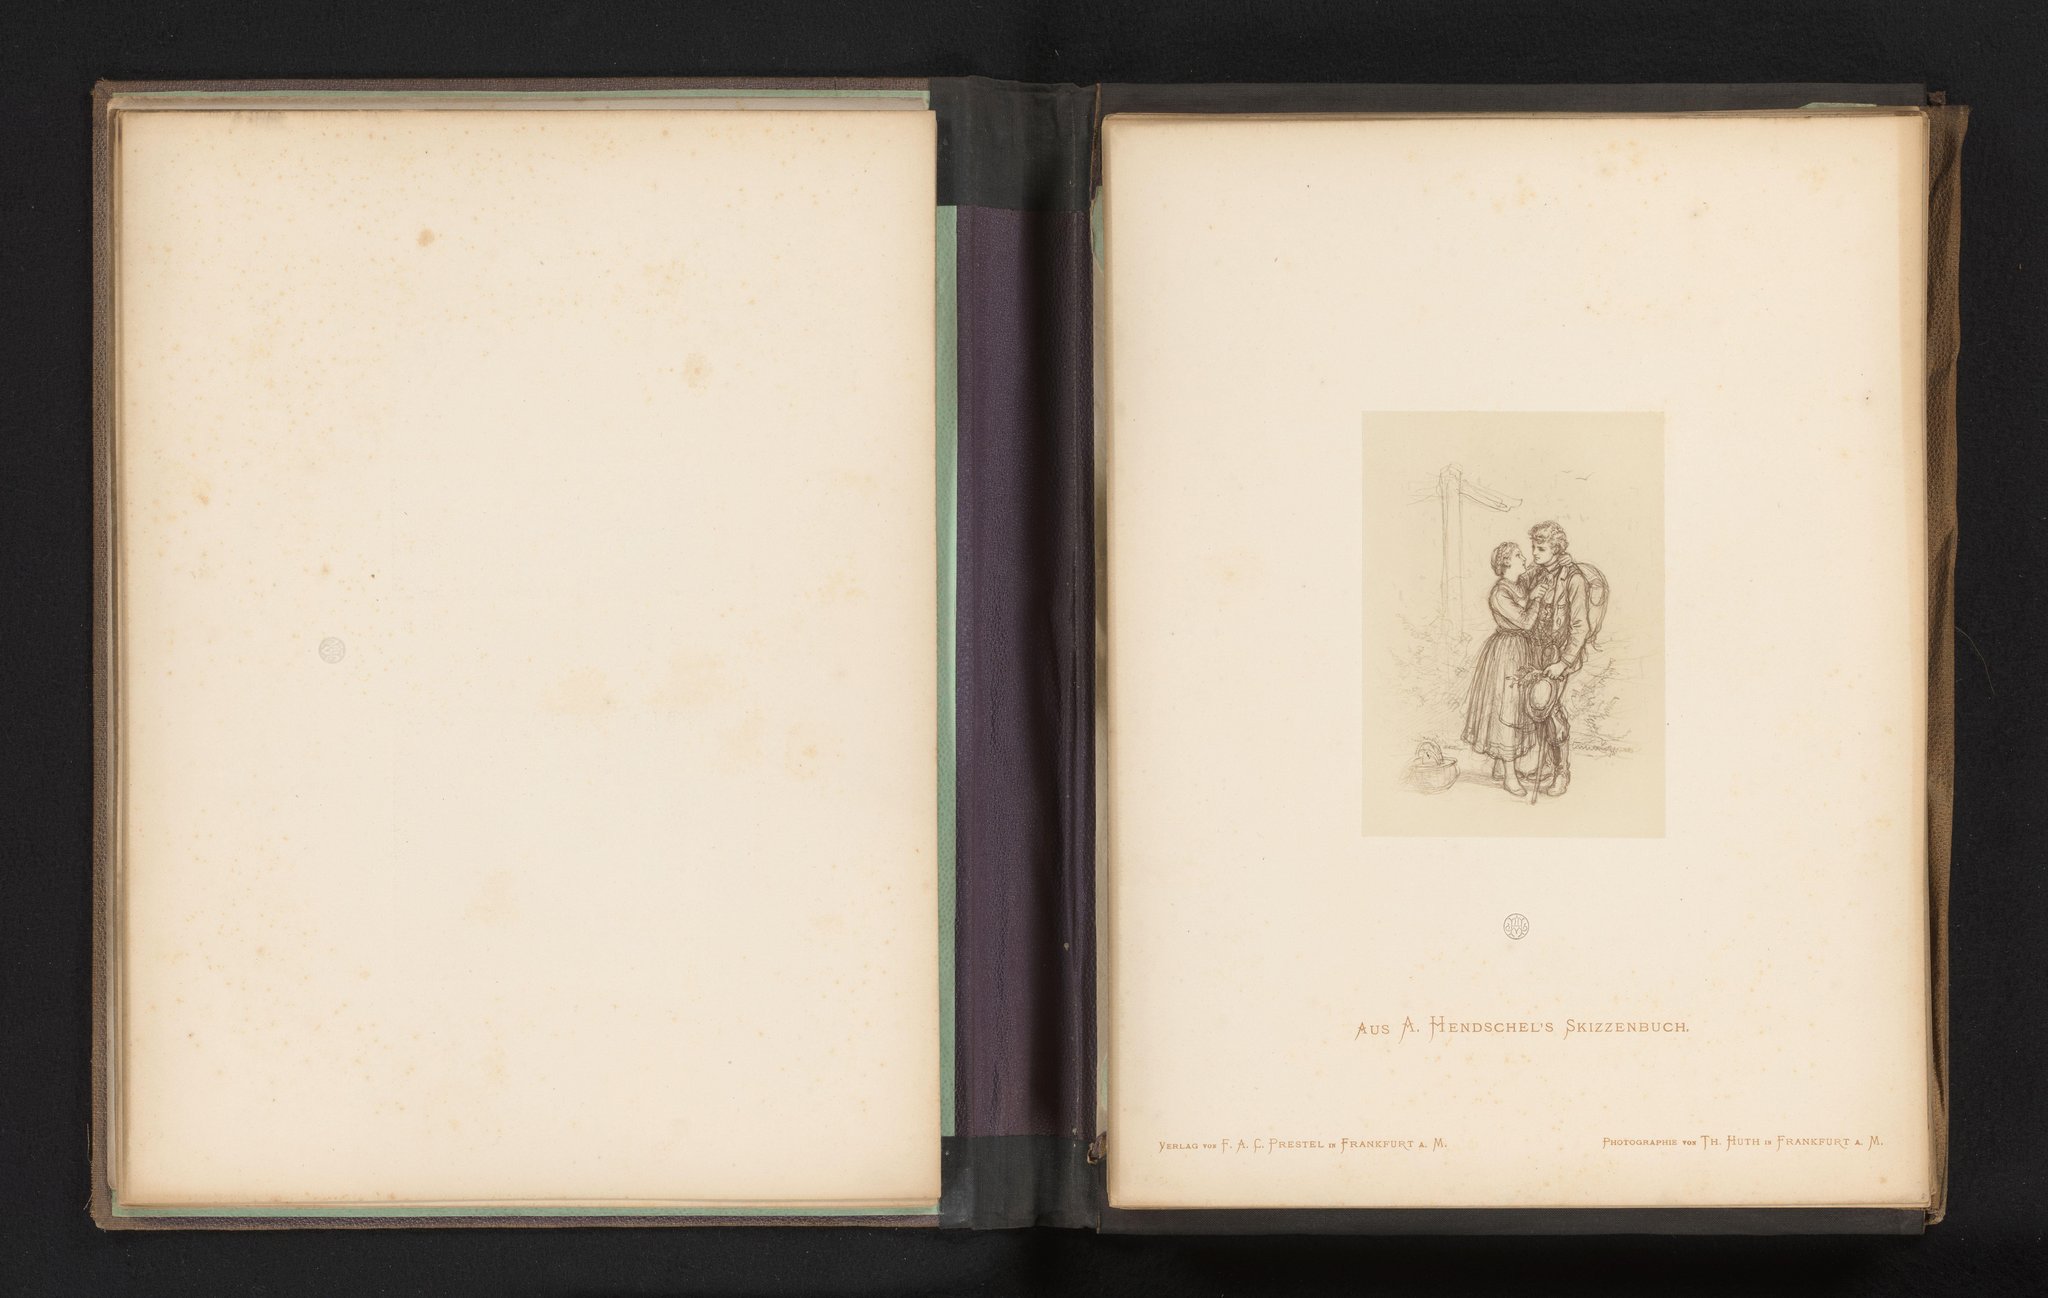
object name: reproduction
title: Fotoreproductie van een schets van het afscheid van een liefdespaar door Albert Hendschel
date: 1865-1870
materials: paper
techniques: albumen print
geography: frankfurt am main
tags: couple of lovers, taking leave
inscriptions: monogram: ‘AH’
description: Deze foto maakt deel uit van een omslag met 50 foto's op 48 bladen, een lijst van afbeeldingen en een titelblad.